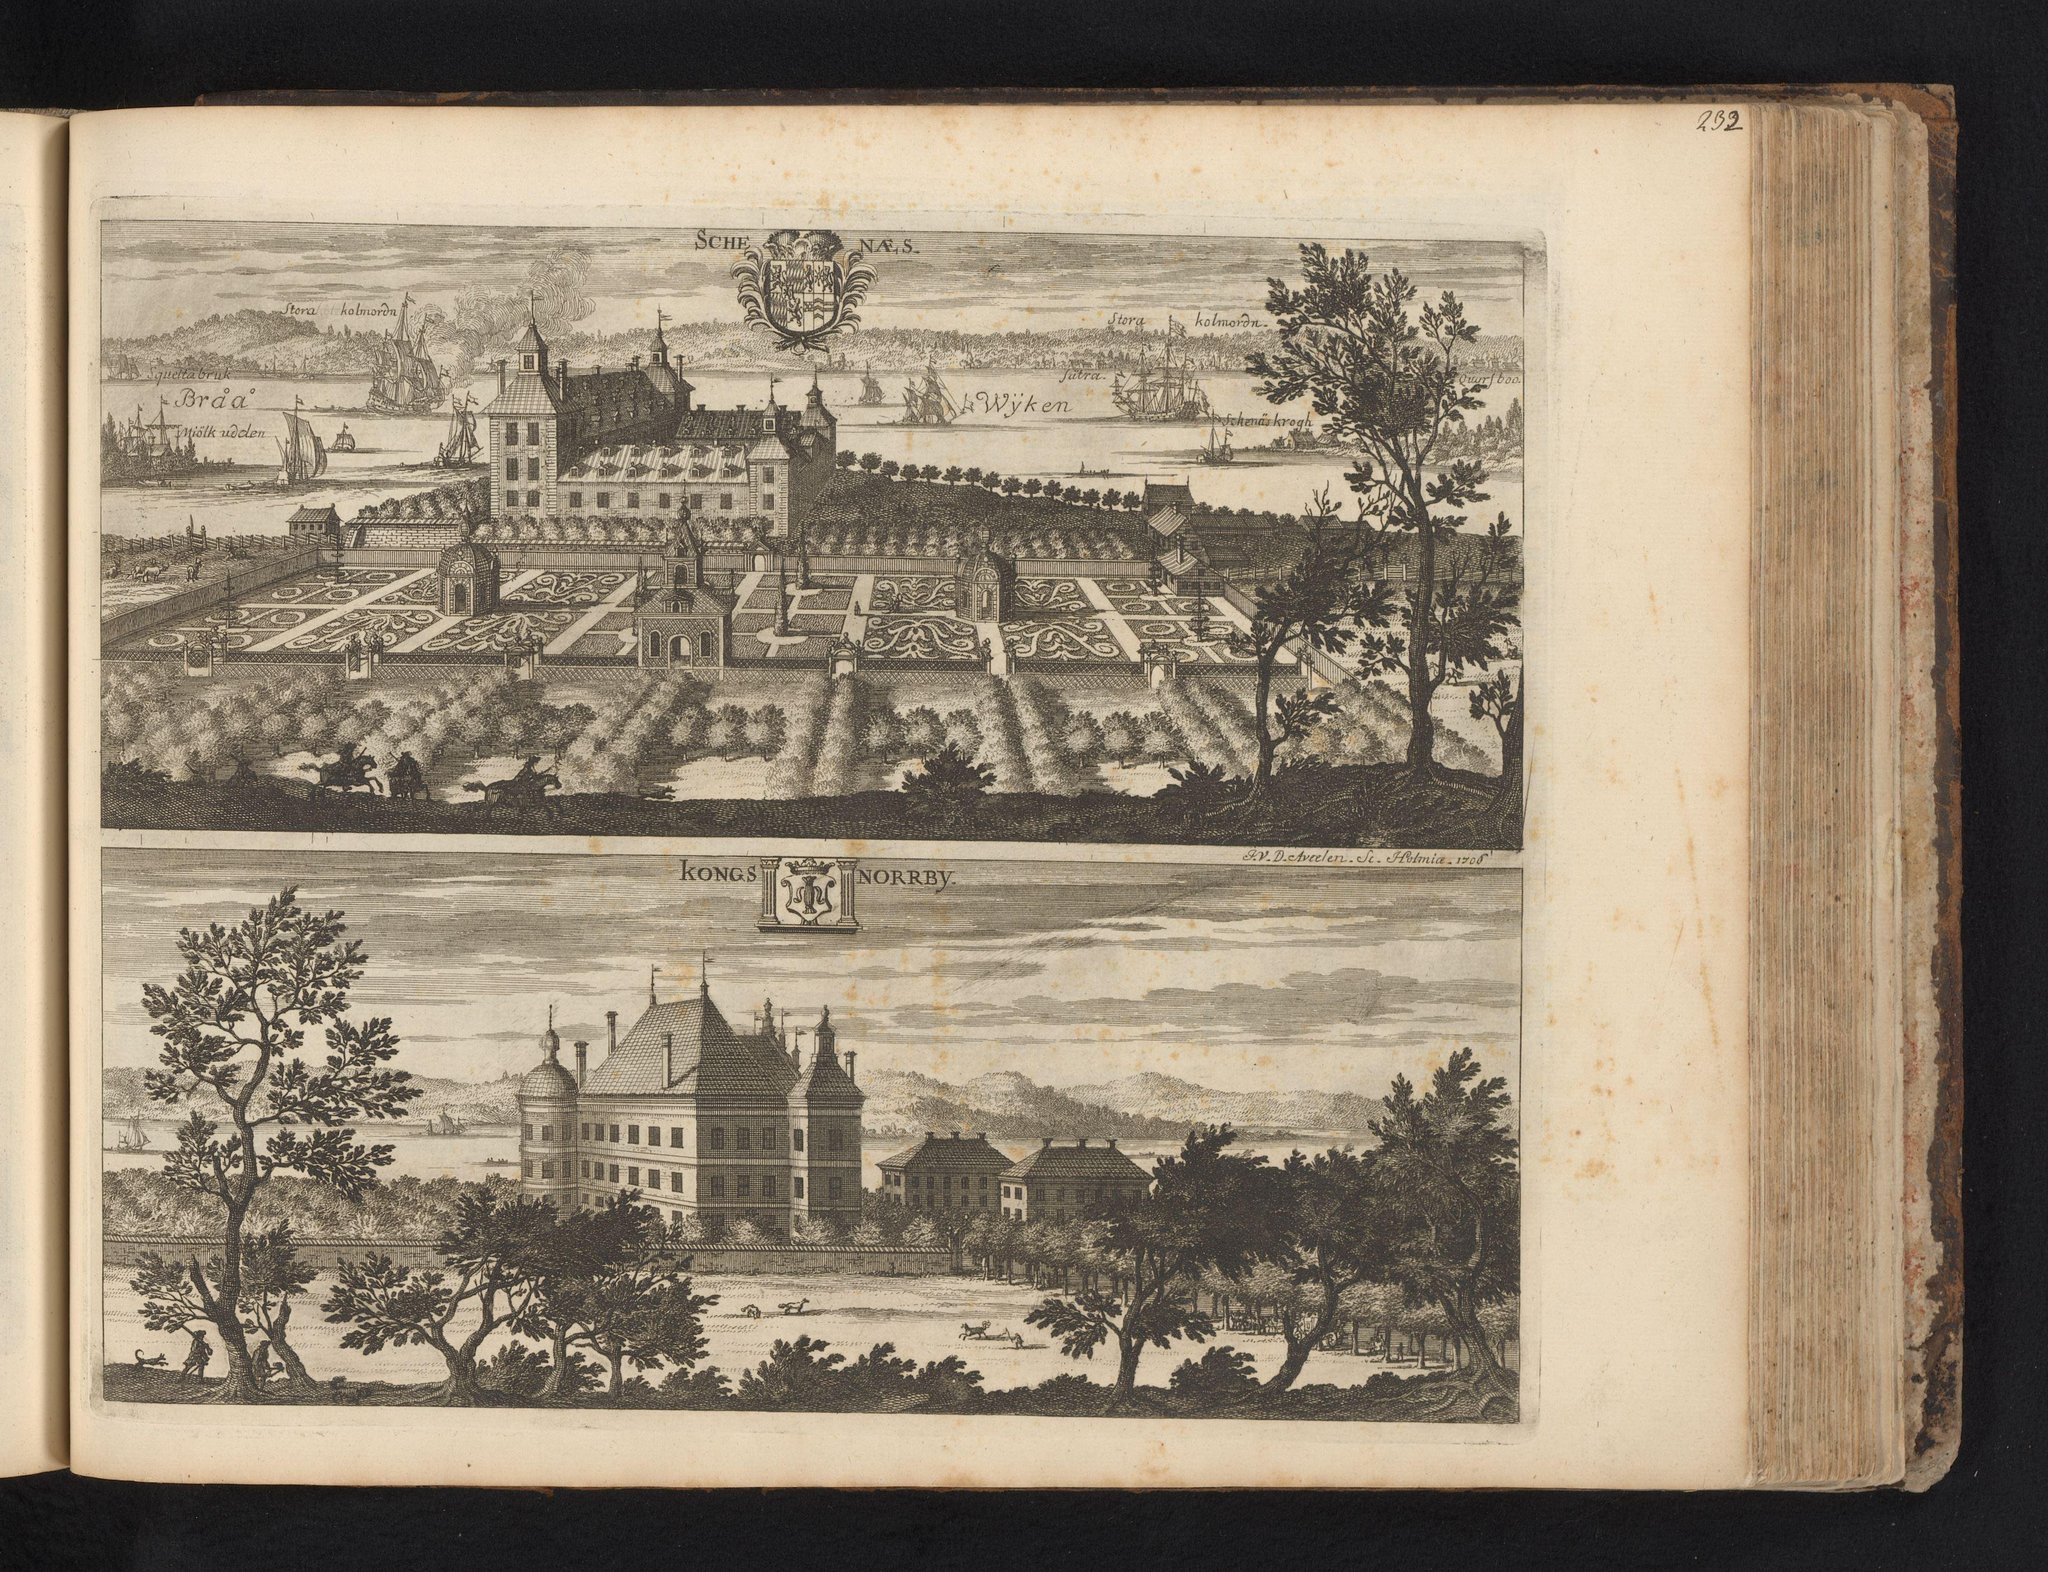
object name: print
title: Gezicht op slot Skenäs en slot Kungs Norrby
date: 1706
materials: paper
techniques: etching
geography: stockholm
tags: housing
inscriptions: date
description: Kungliga Biblioteket, 'Suecia': http://www.kb.se/samlingarna/Kartor-bilder/Suecia-antiqua/ (geraadpleegd november 2016).